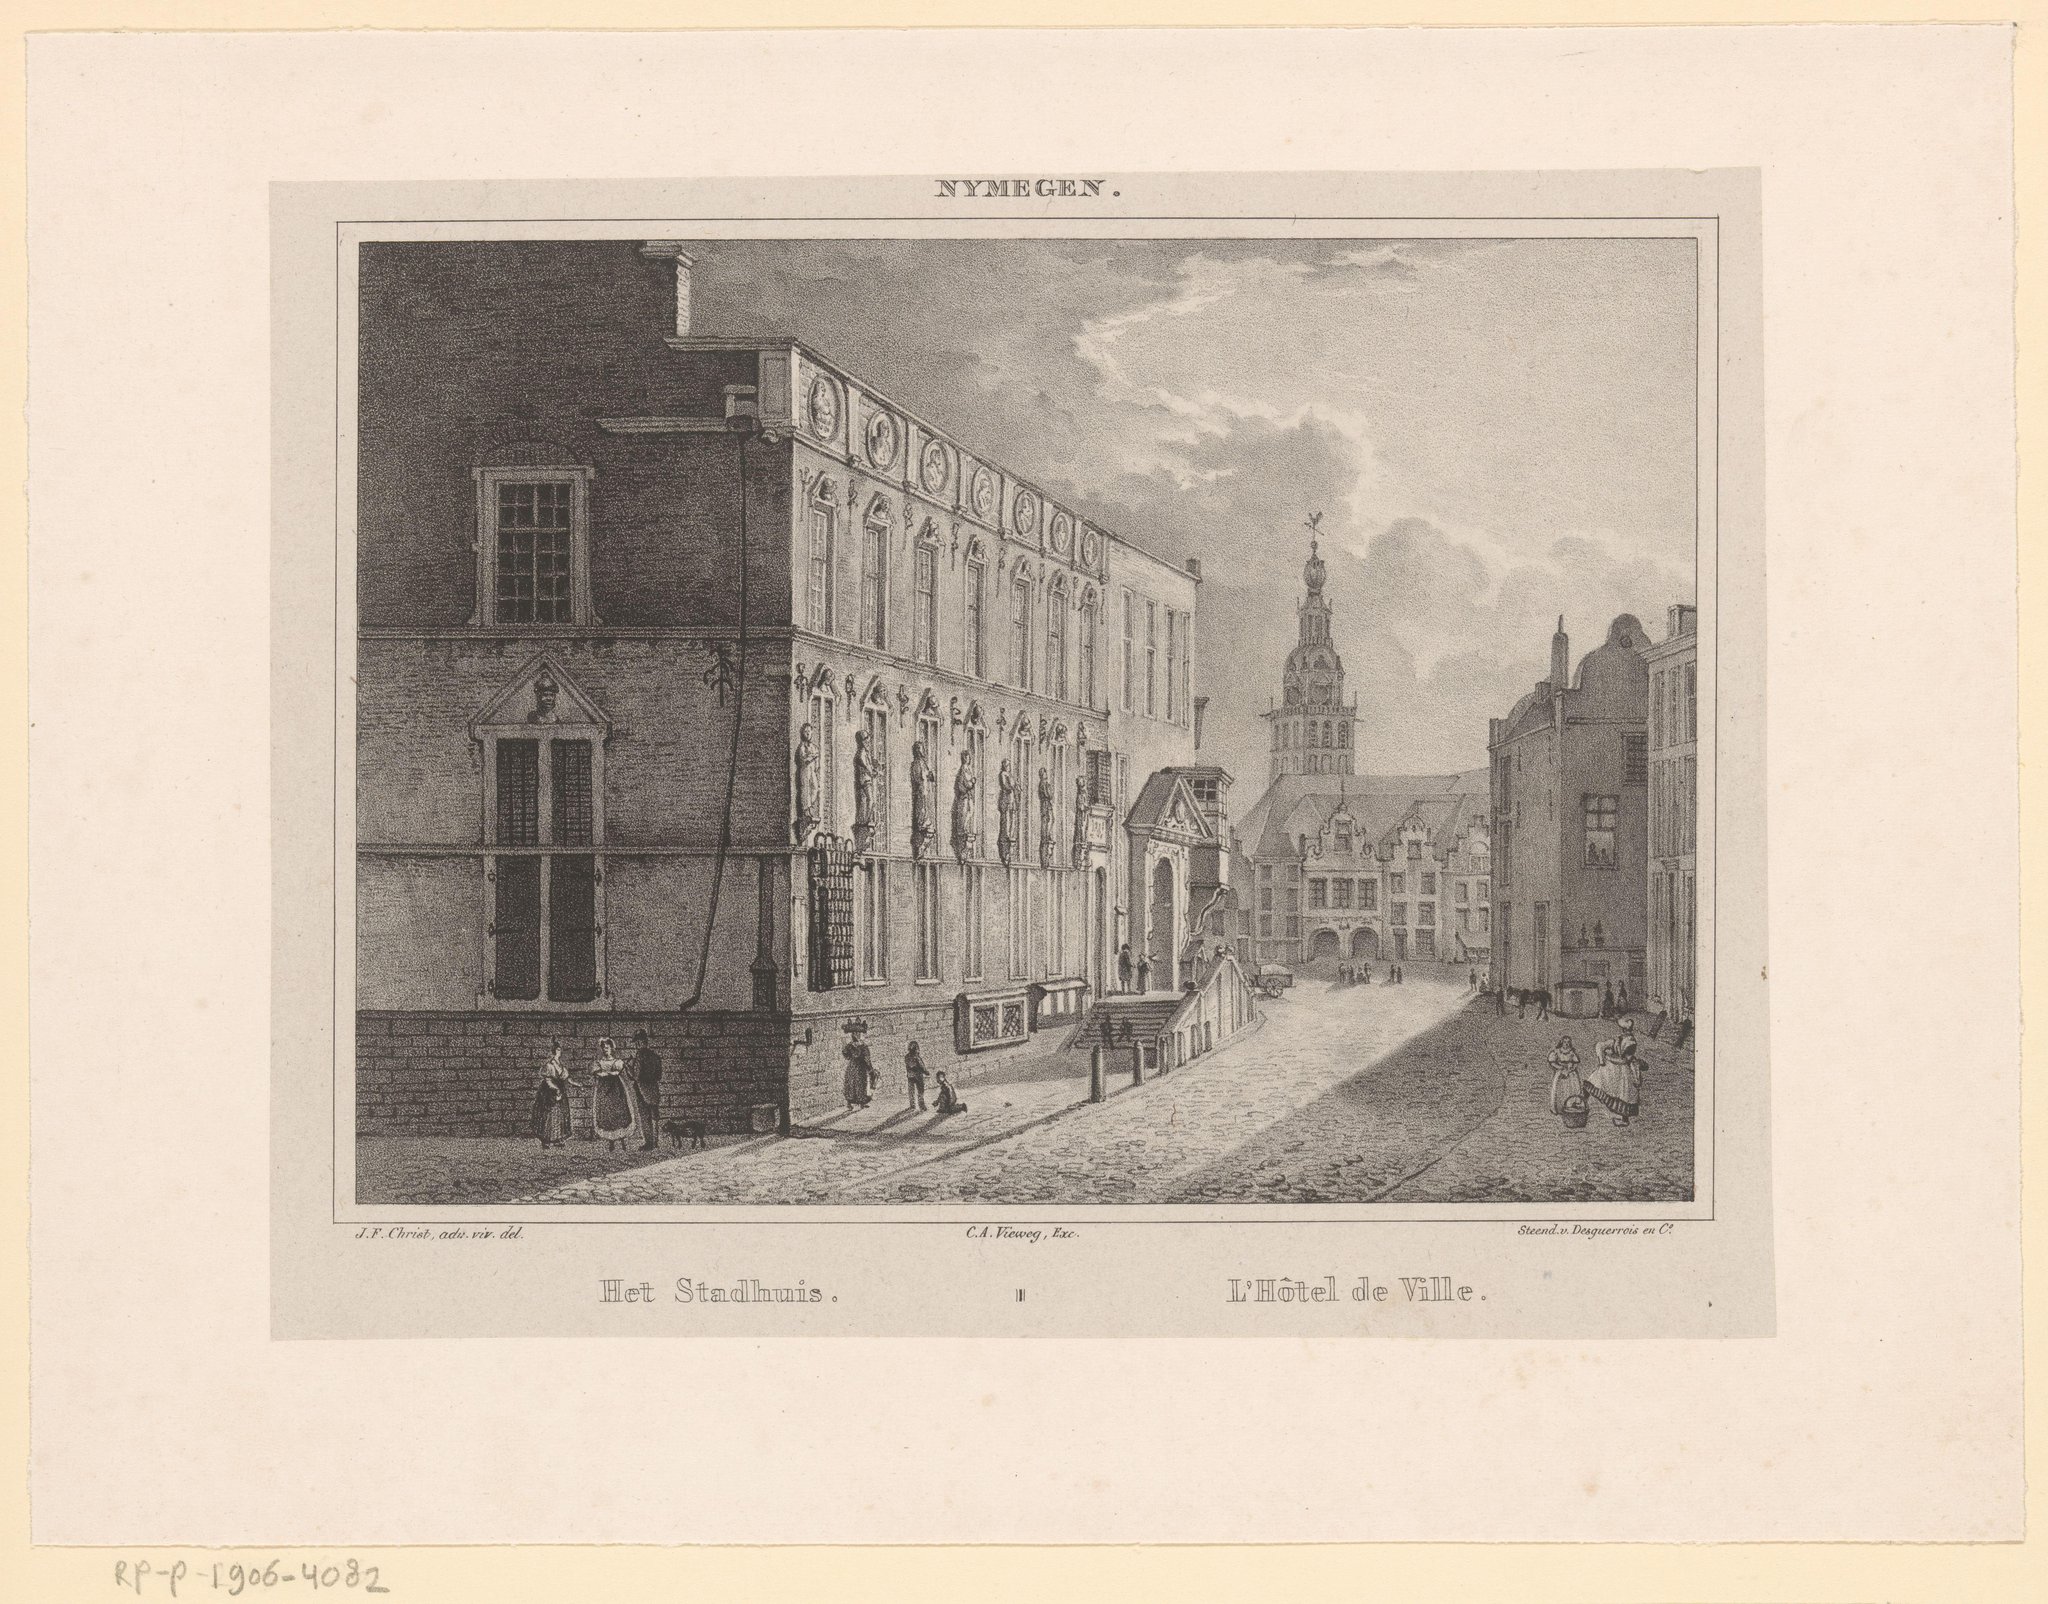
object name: print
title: Zes Gezigten der Stad Nymegen / Six vues de Ville de Nimègue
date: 1834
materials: paper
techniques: lithograph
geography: nijmegen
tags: townhall, street (+ city(-scape) with figures, staffage)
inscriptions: collector's mark: Lugt 2228